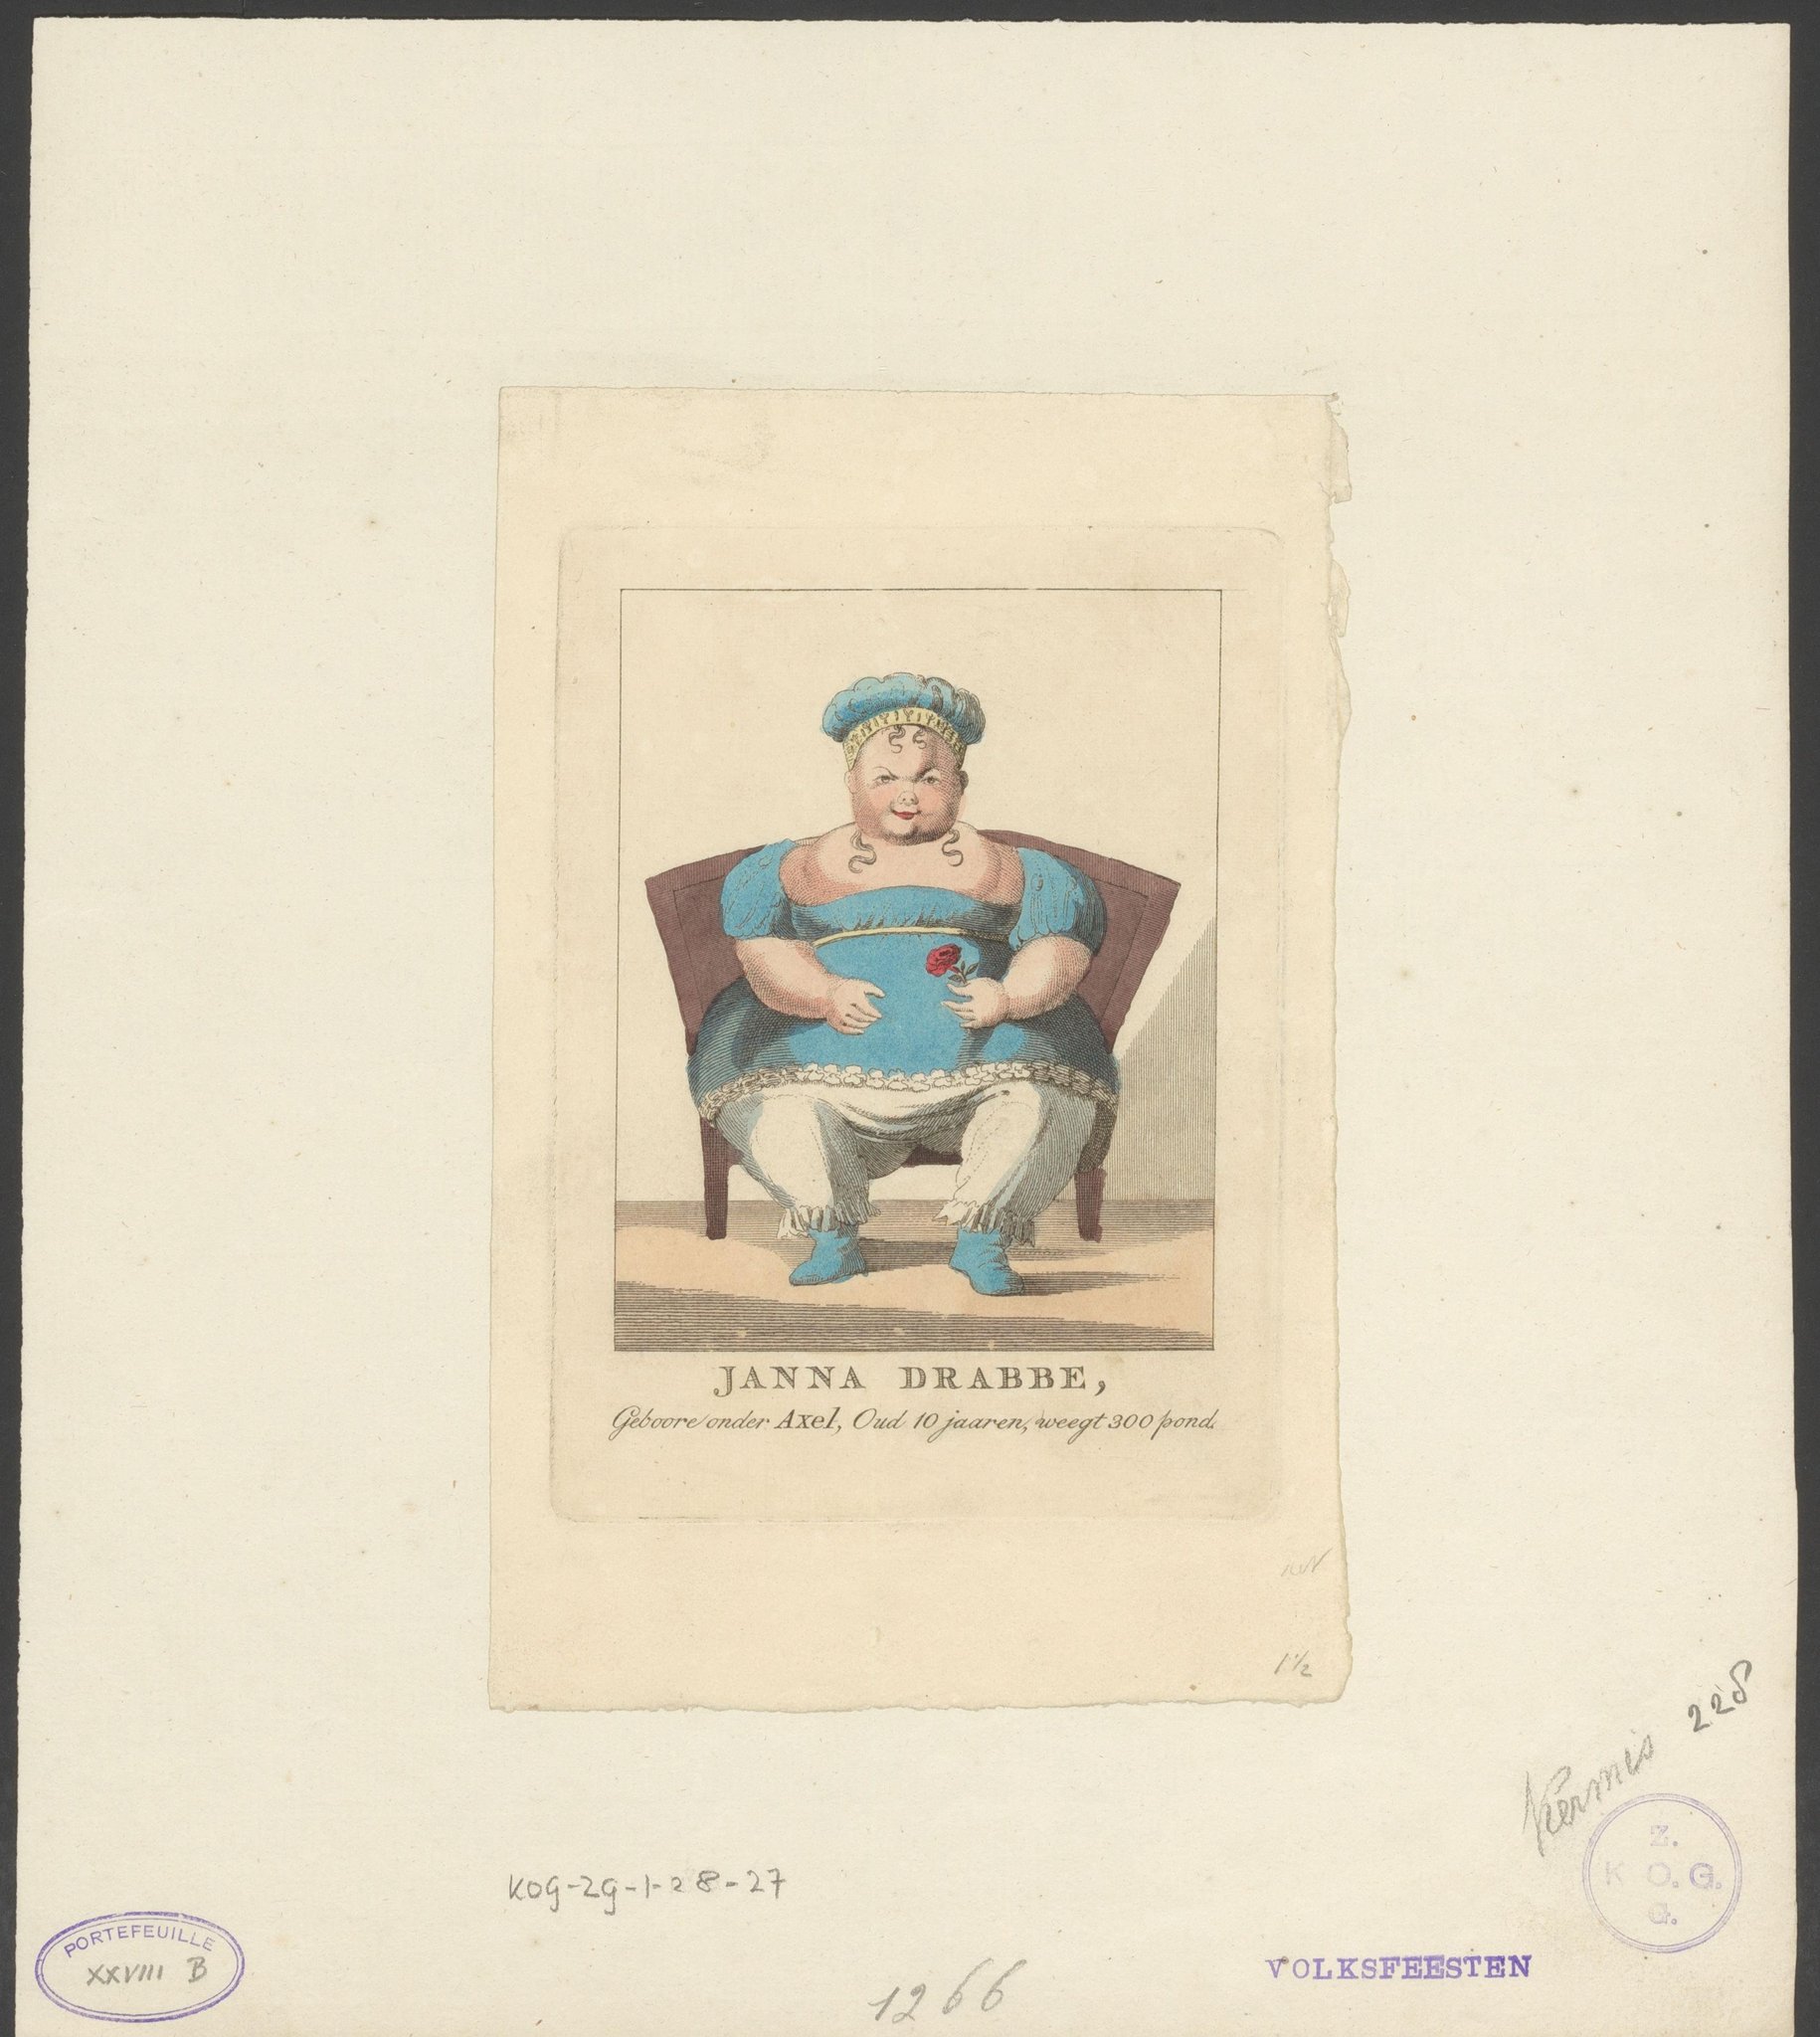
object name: print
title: Jana Drabbe, zittend op een stoel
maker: Anonymous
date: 1819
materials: paper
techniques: engraving, etching, hand coloring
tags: human monstrosities ~ freak show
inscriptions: stamp, stamp, collector's mark: Lugt 1641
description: De prent werd verkocht op de plaatsten waar Jana tentoon werd gesteld. Onderwerpsrubrieken binnen de Atlas Zeden en Gewoonten: Zeden en Gewoonten in Engeren Zin. Volksleven. Volksfeesten. Kermistypen, wondermenschen en dergelijken.